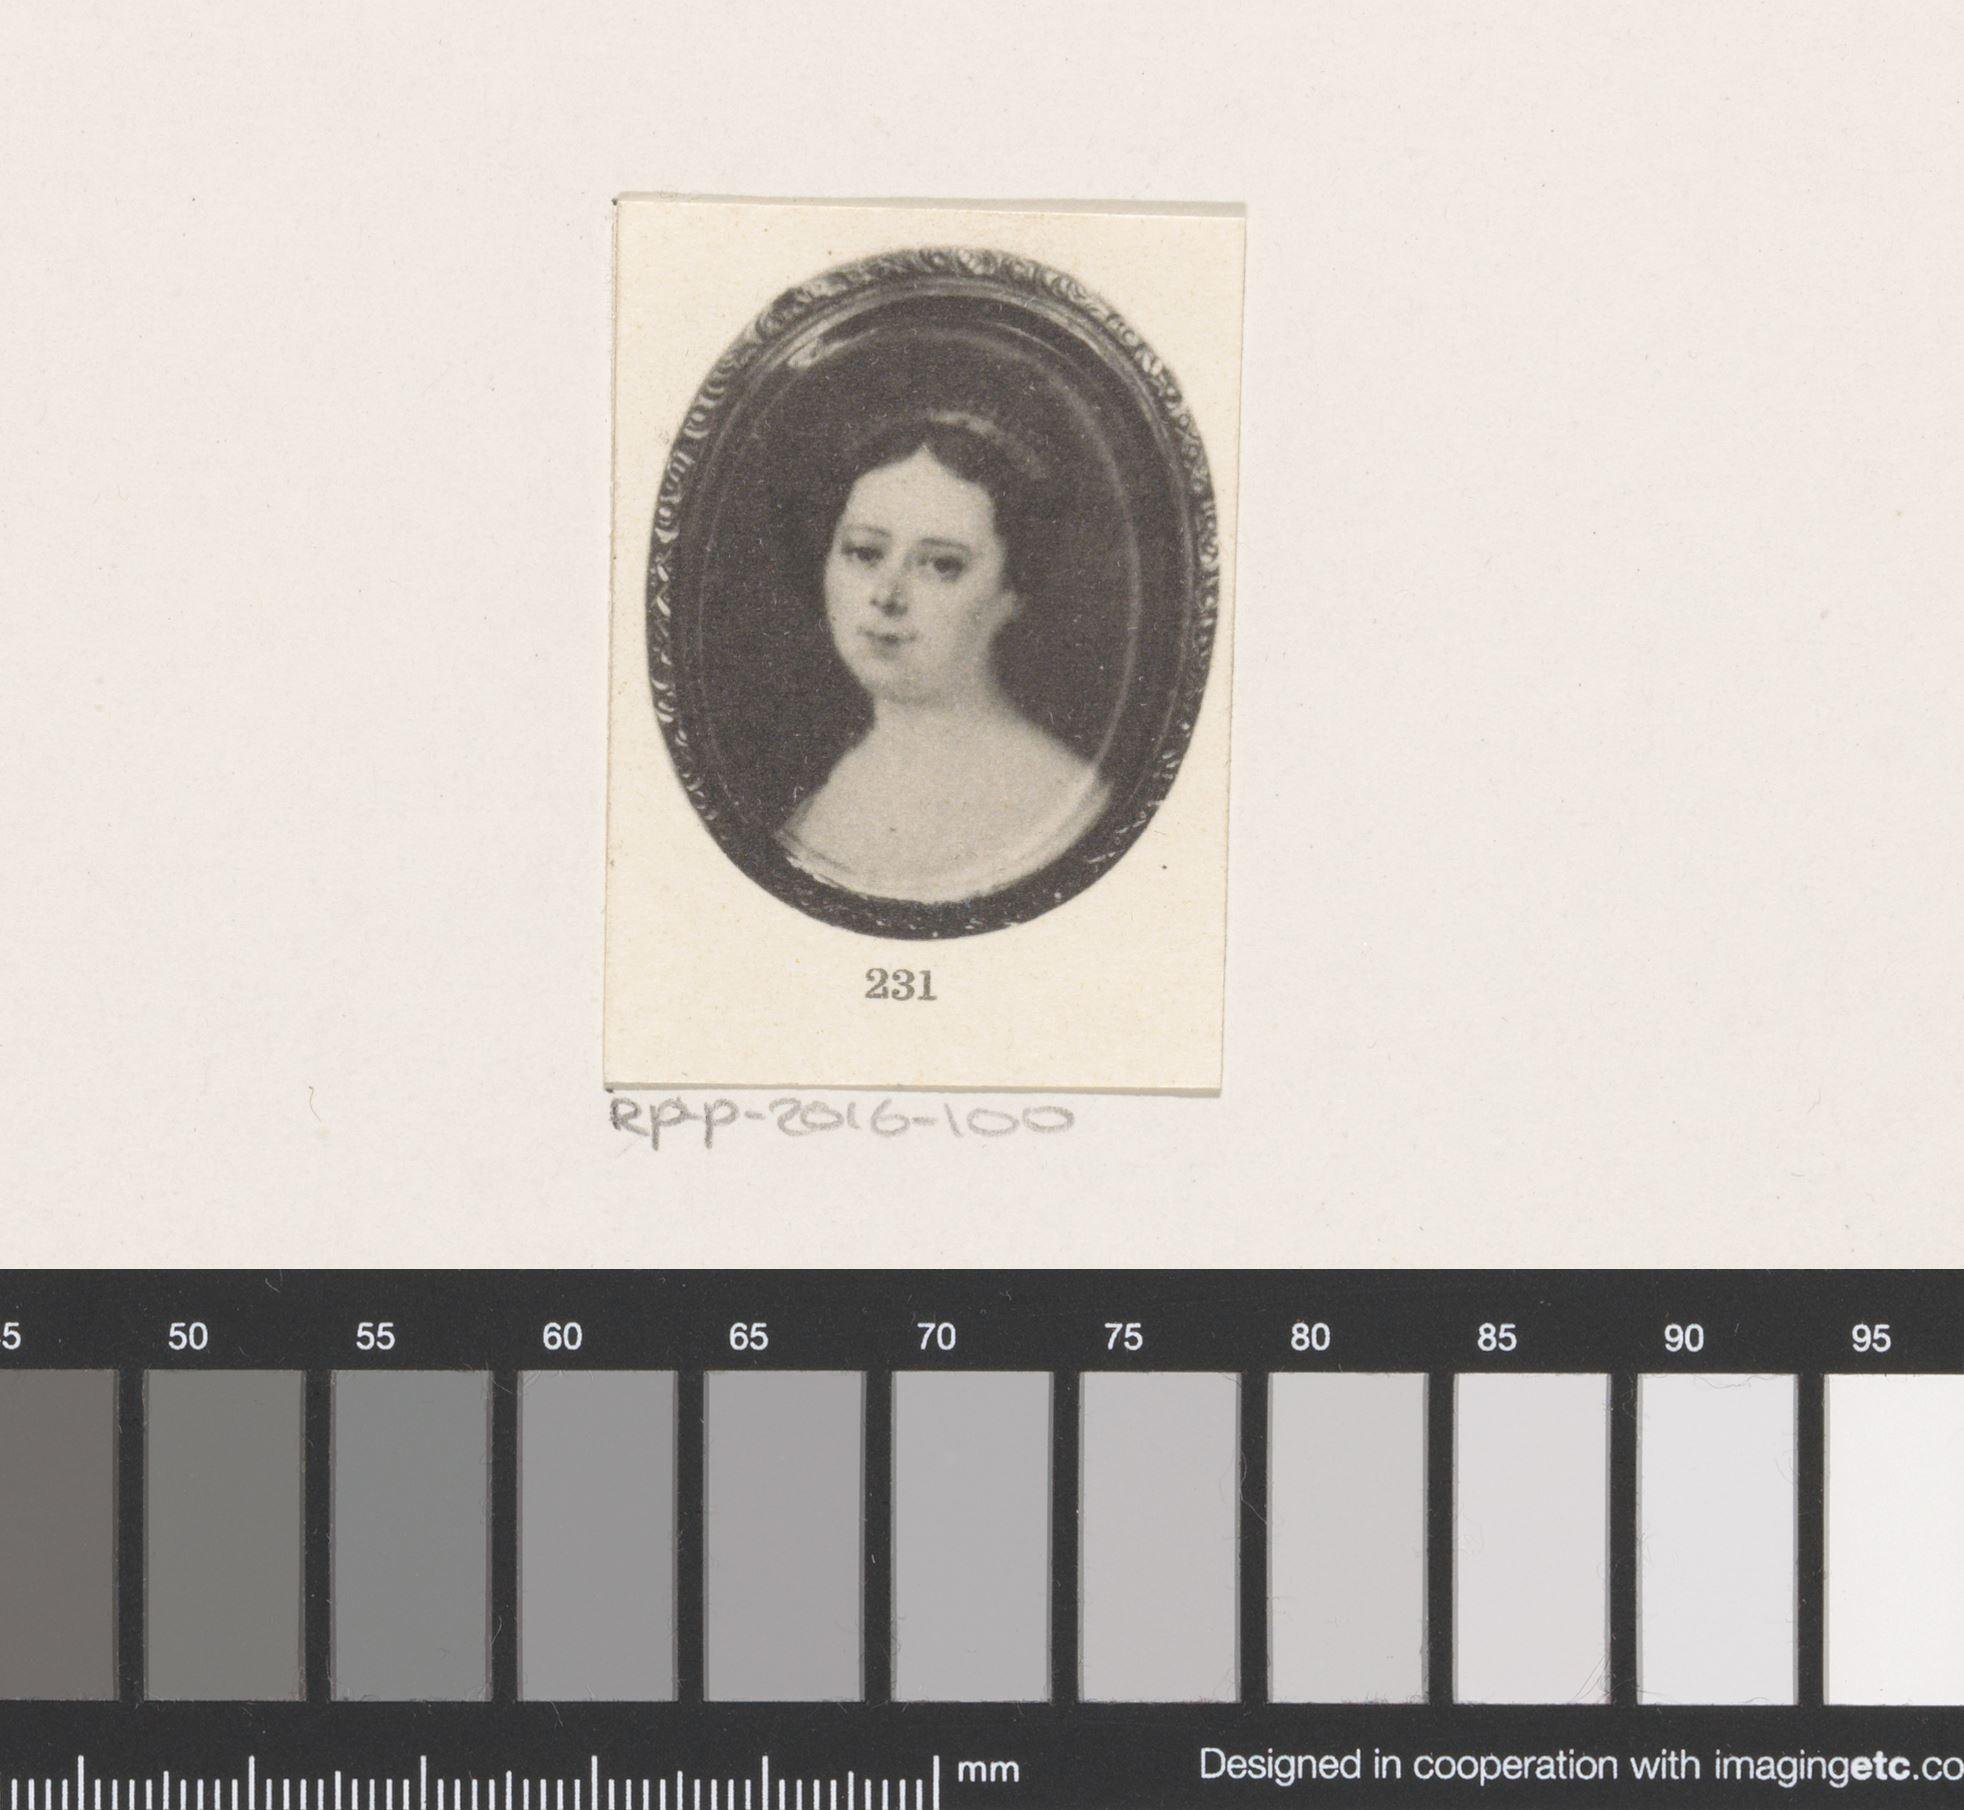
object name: photomechanical print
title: Portret van Laure Junot, hertogin van Abrantès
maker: Anonymous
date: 1850-1949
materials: paper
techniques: photograph, letterpress printing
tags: paris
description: Portret van Laure Junot in een geornamenteerde, ovale omlijsting. In de ondermarge in boekdruk: 231.